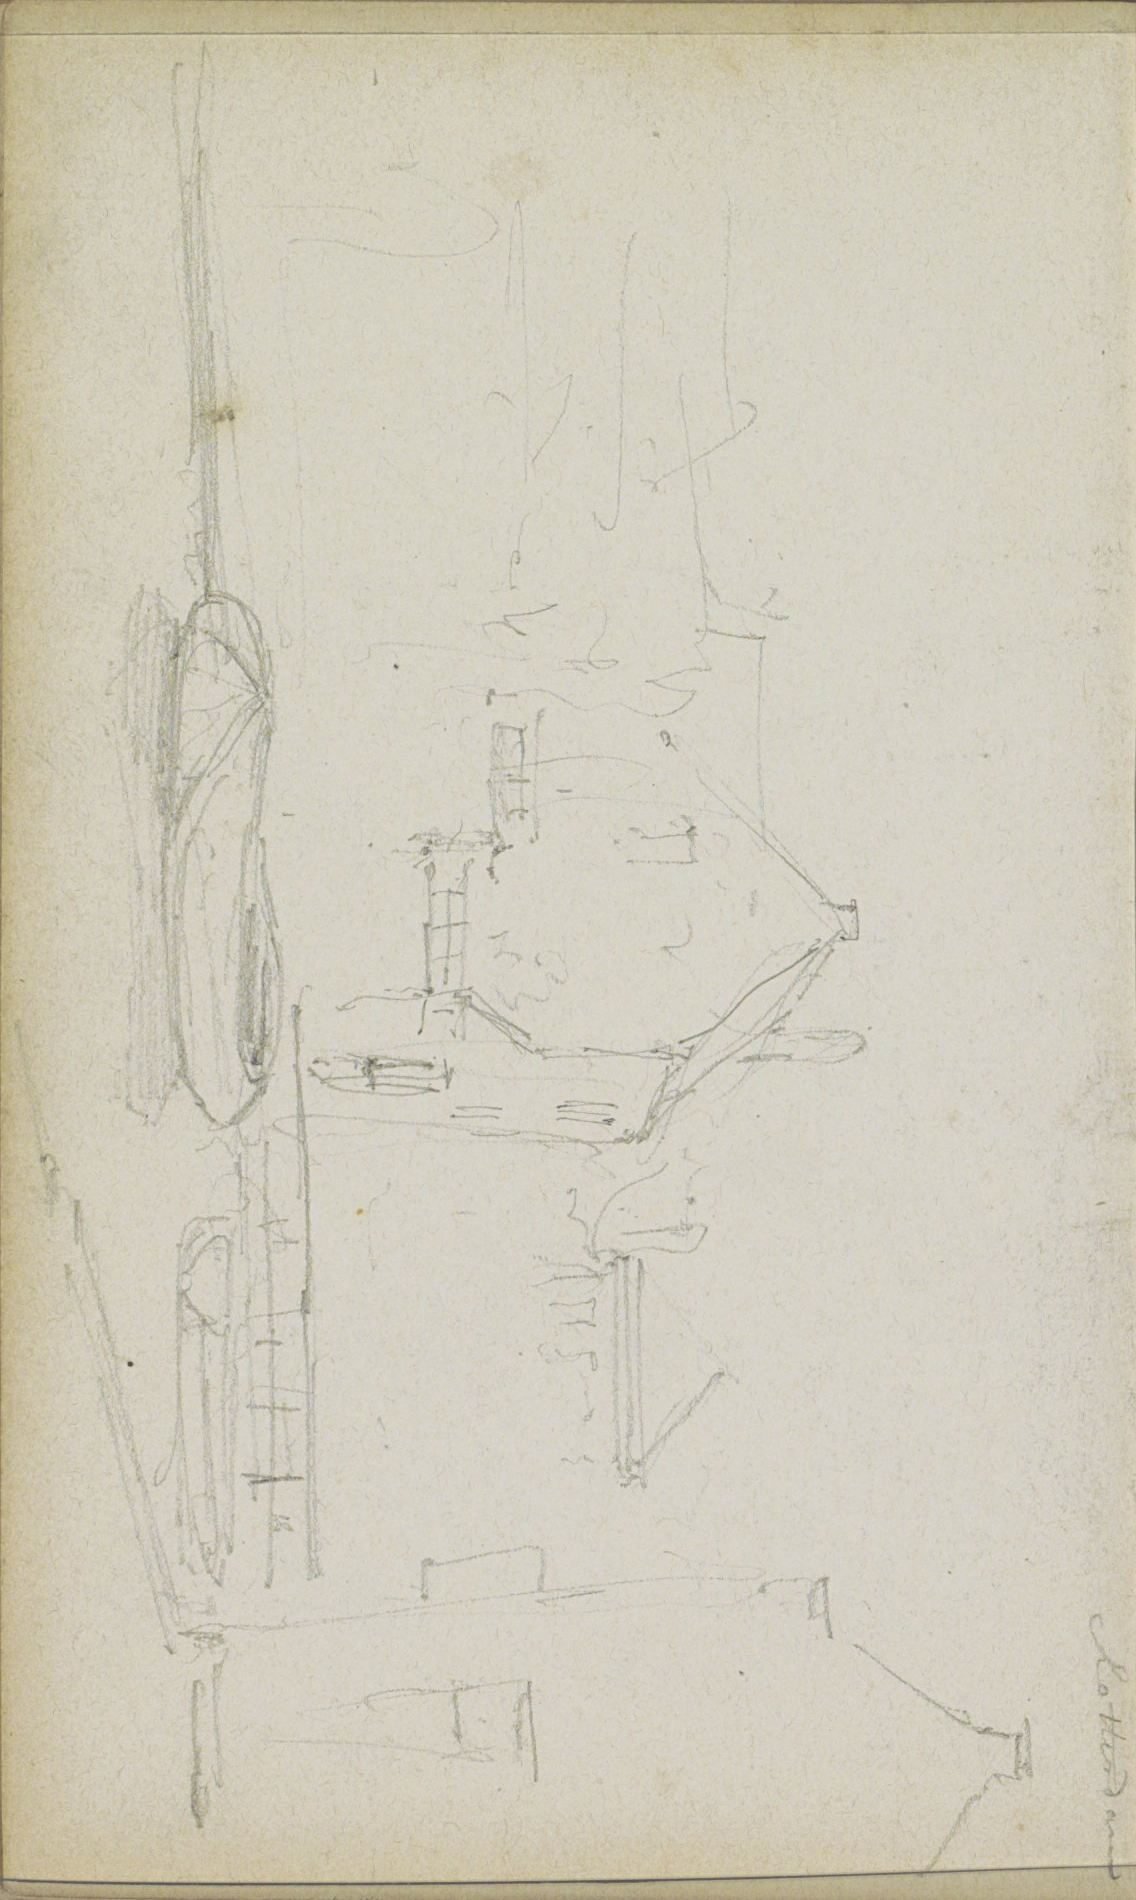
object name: sketchbook leaf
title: Stadsgezicht in Rotterdam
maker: adrianus eversen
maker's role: draughtsman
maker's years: 1818-1897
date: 1828-1897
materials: paper, pencil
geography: rotterdam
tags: urban housing, rowing-boat, canoe, etc., bridge in city across river, canal, etc., rotterdam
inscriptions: annotation: ‘Rotterdam’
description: Gezicht op een gracht met een brug te Rotterdam. Vooraan een roeiboot. Op de achtergrond gebouwen. Blad 62 verso uit een schetsboek met 69 bladen vervaardigd in de omgeving van Delft, Rotterdam, Oudewater en Harlingen.